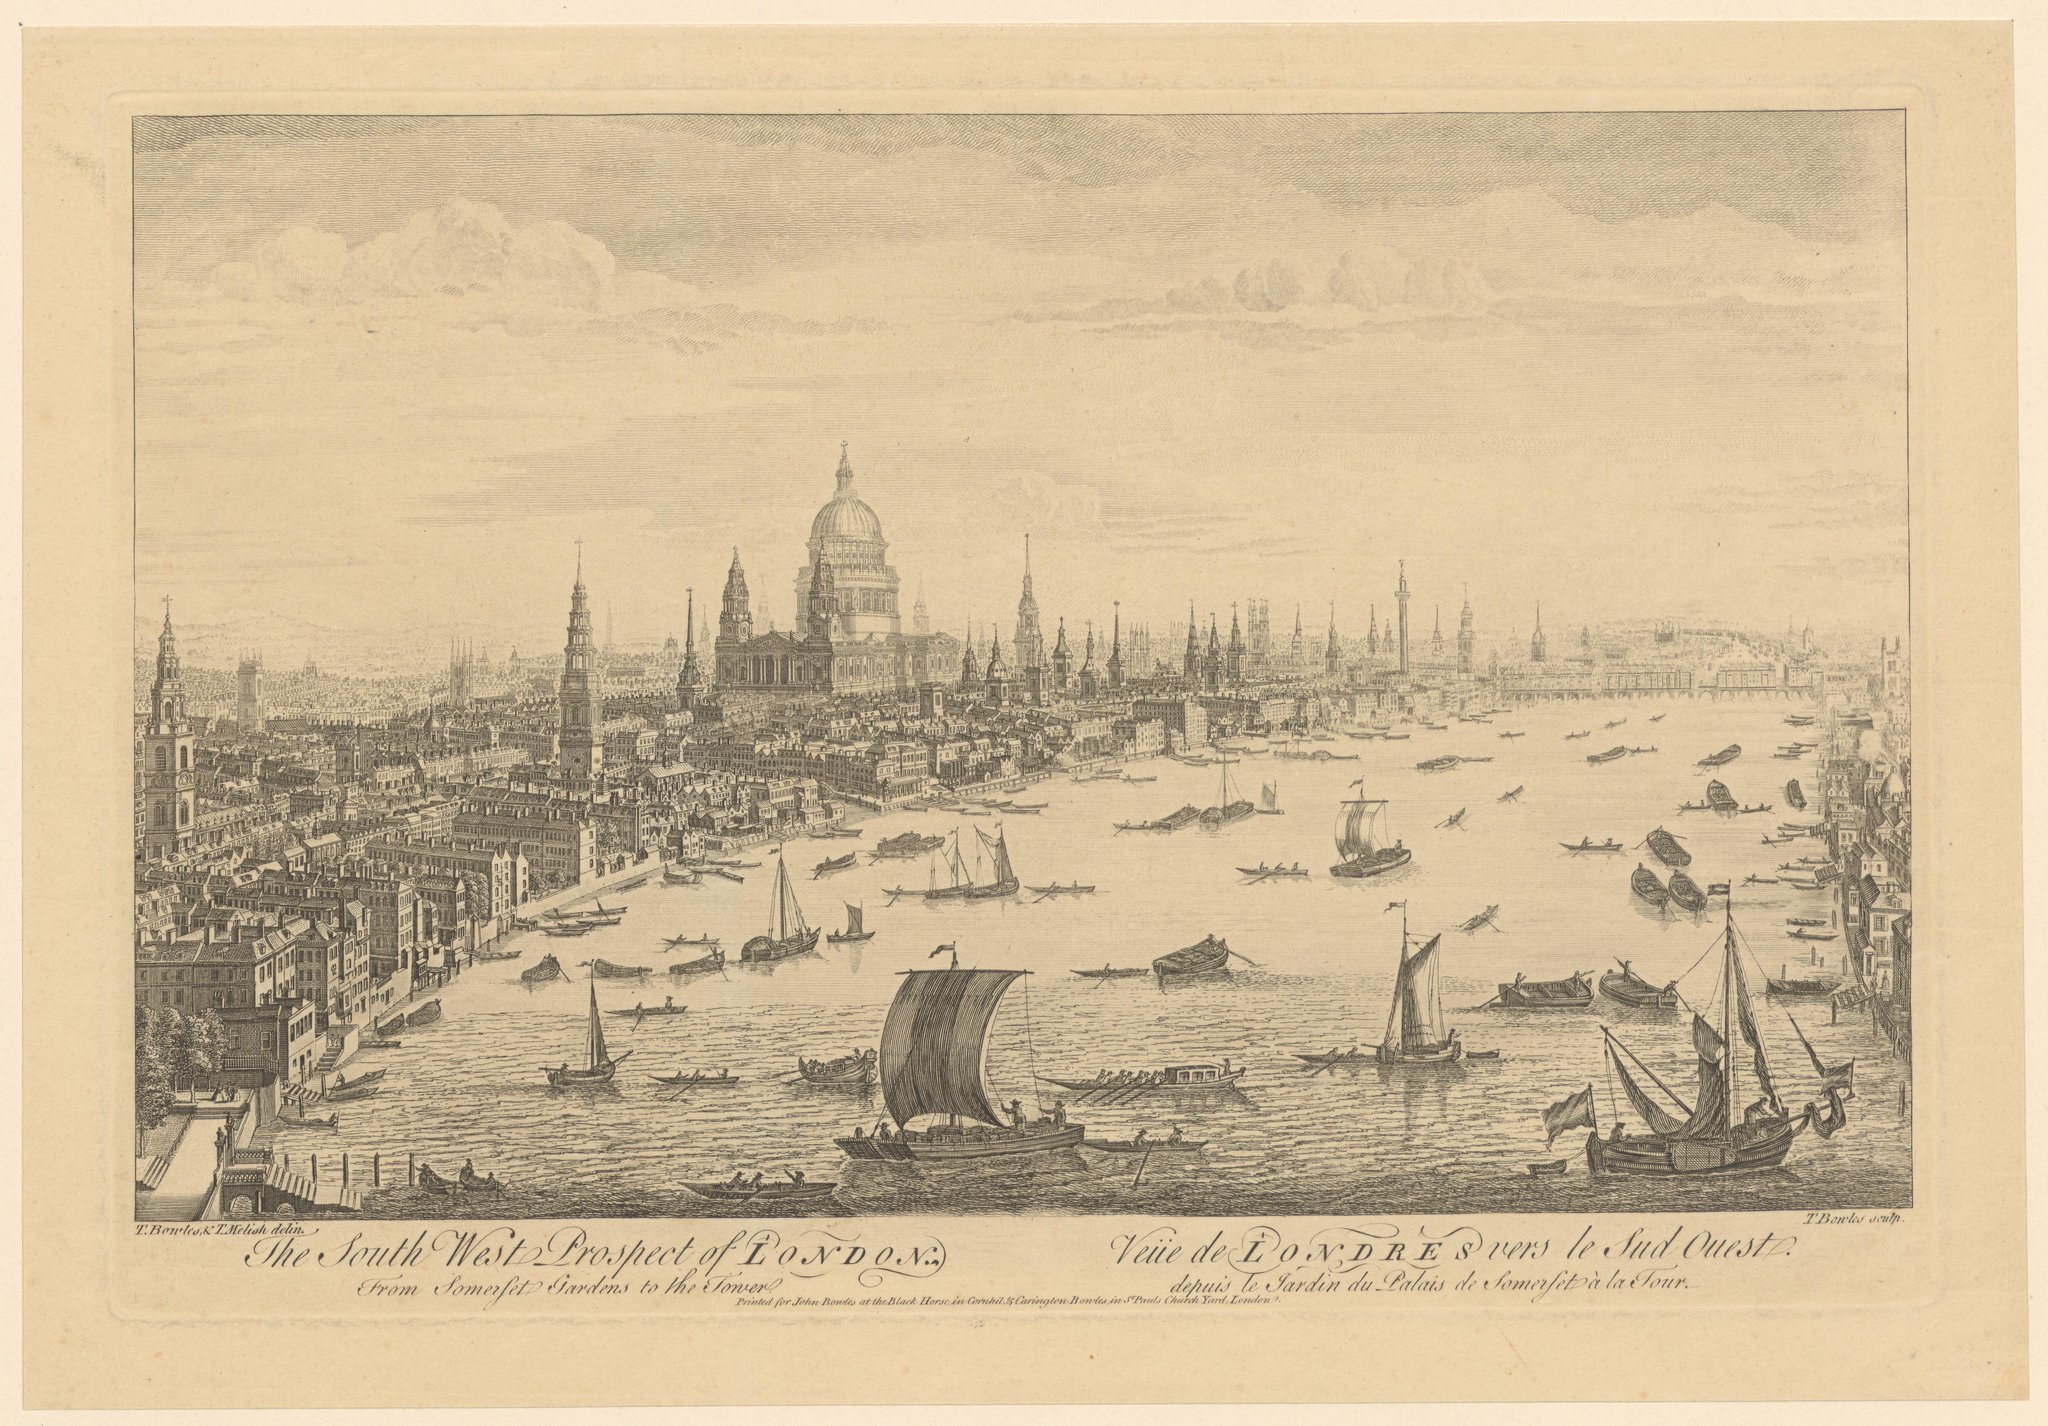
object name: print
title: The South West Prospect of London, from Somerset Gardens to the Tower / Veüe de Londres vers le Sud Ouest, depuis le Jardin du Palais de Somerset a la Tour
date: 1752-1766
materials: paper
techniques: engraving, etching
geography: london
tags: church (exterior), ships (in general) - cc - more than one ship, bridge in city across river, canal, etc., canals, waters (in city) (+ city(-scape) with figures, staffage), thames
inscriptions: collector's mark: Lugt 2228